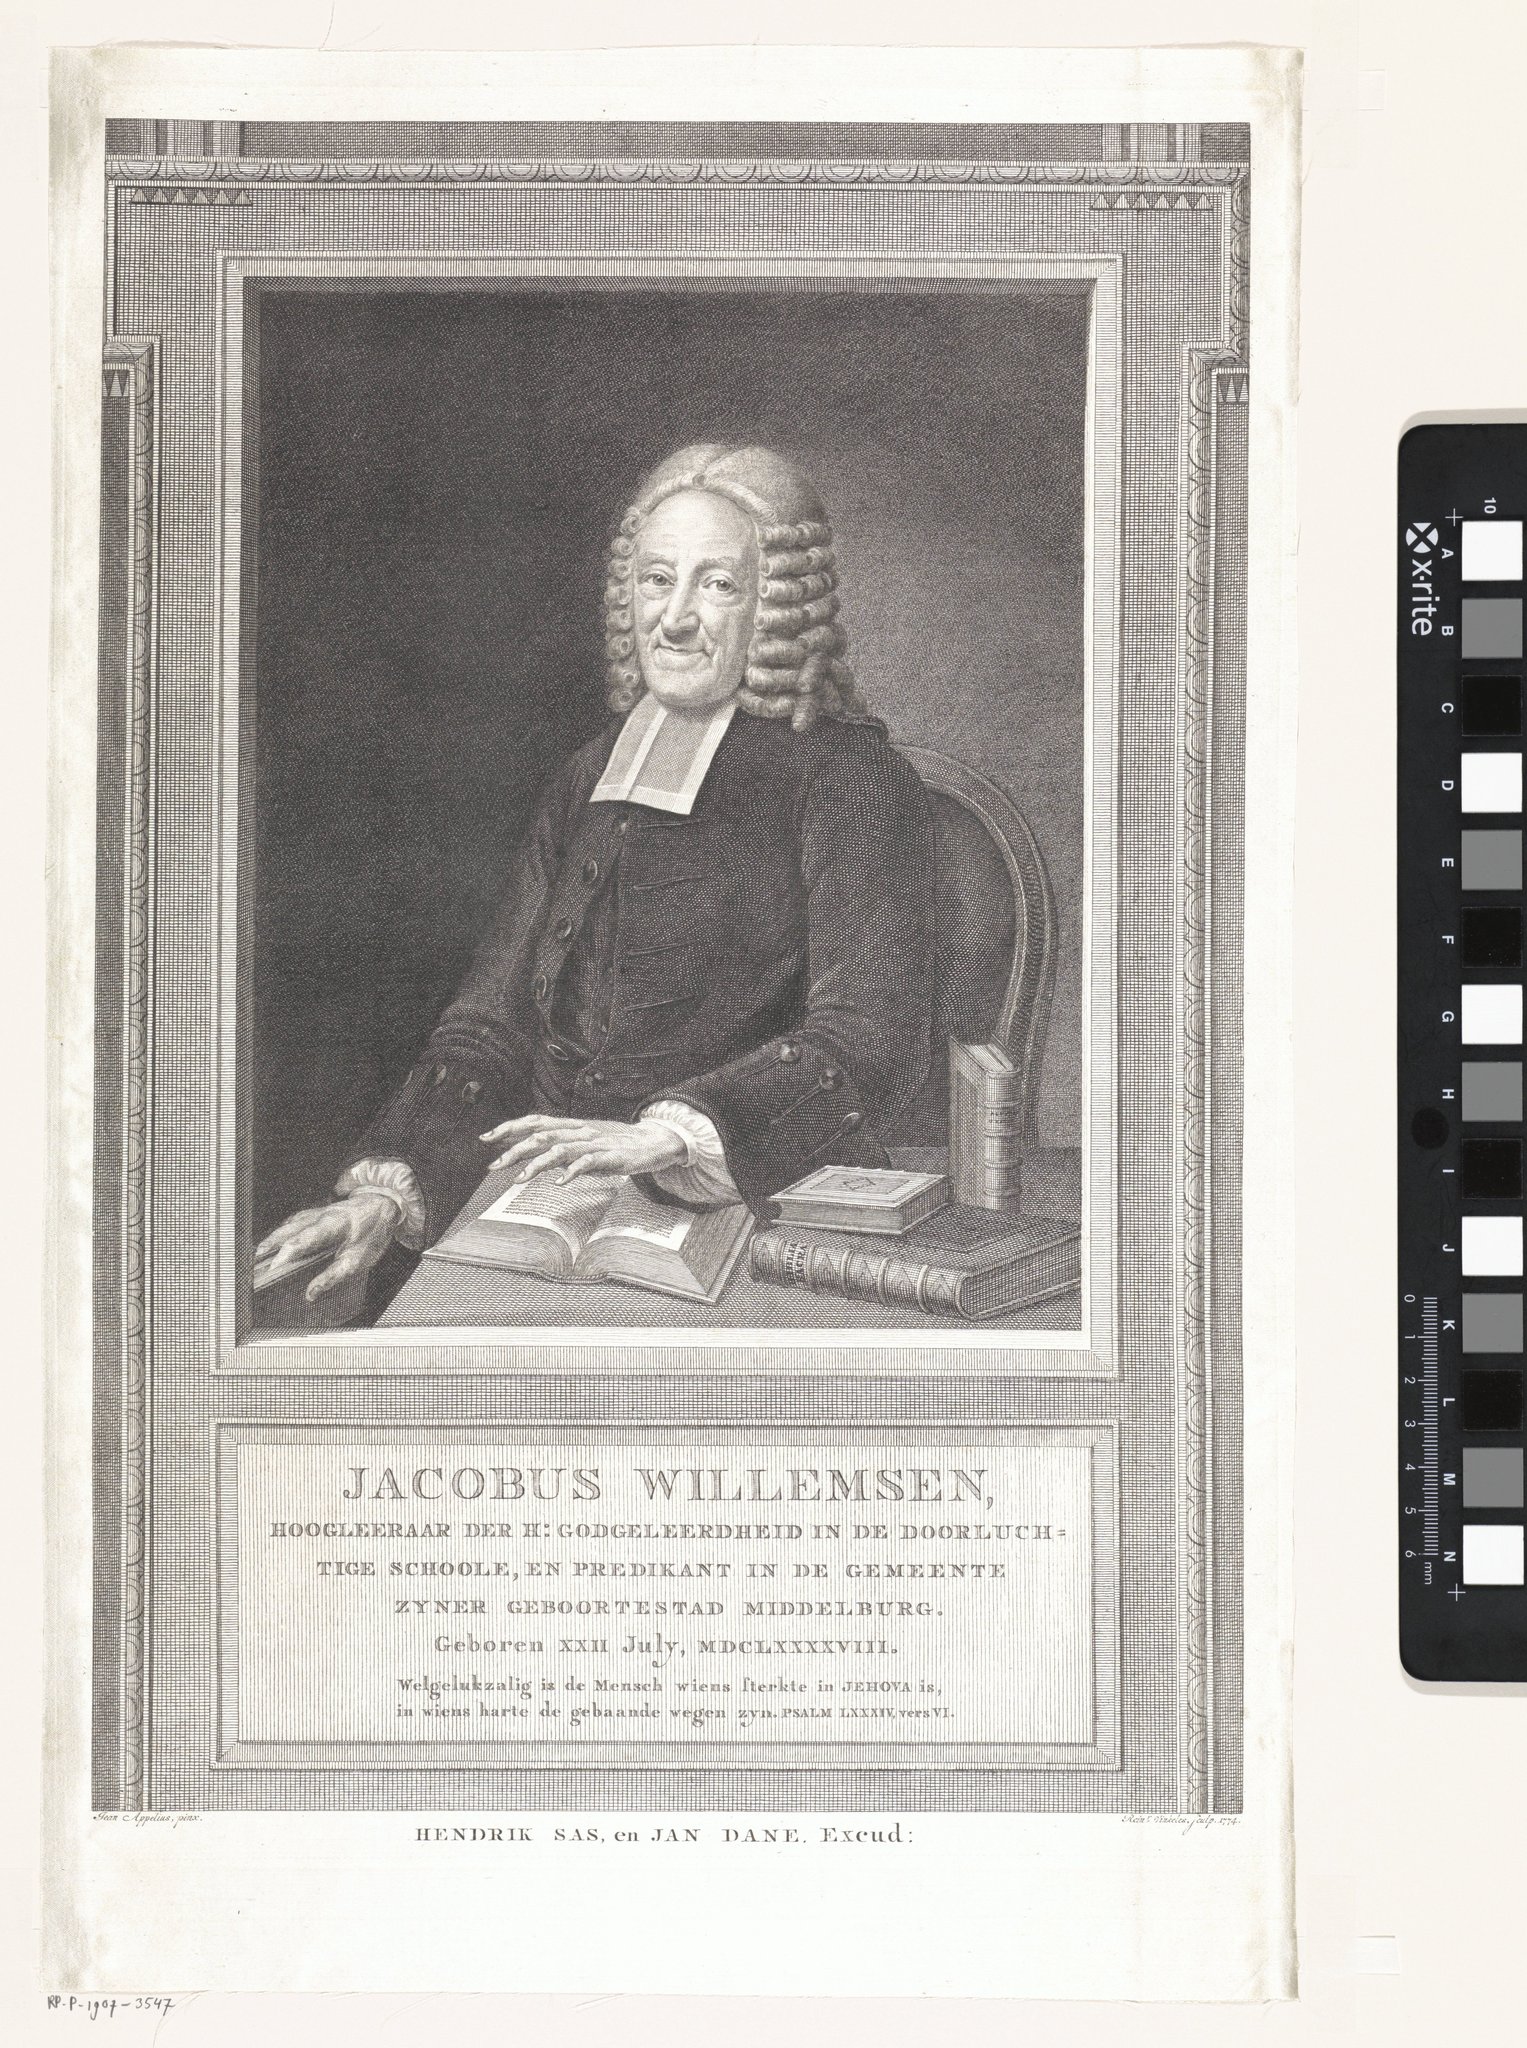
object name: print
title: Portret van Jacobus Willemsen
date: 1774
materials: silk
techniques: engraving, etching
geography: middelburg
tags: middelburg, book - mm - book open, book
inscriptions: date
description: Portret van Jacobus Willemsen, hoogleraar in de theologie en predikant te Middelburg. Voor hem een tafel waarop enkele boeken.